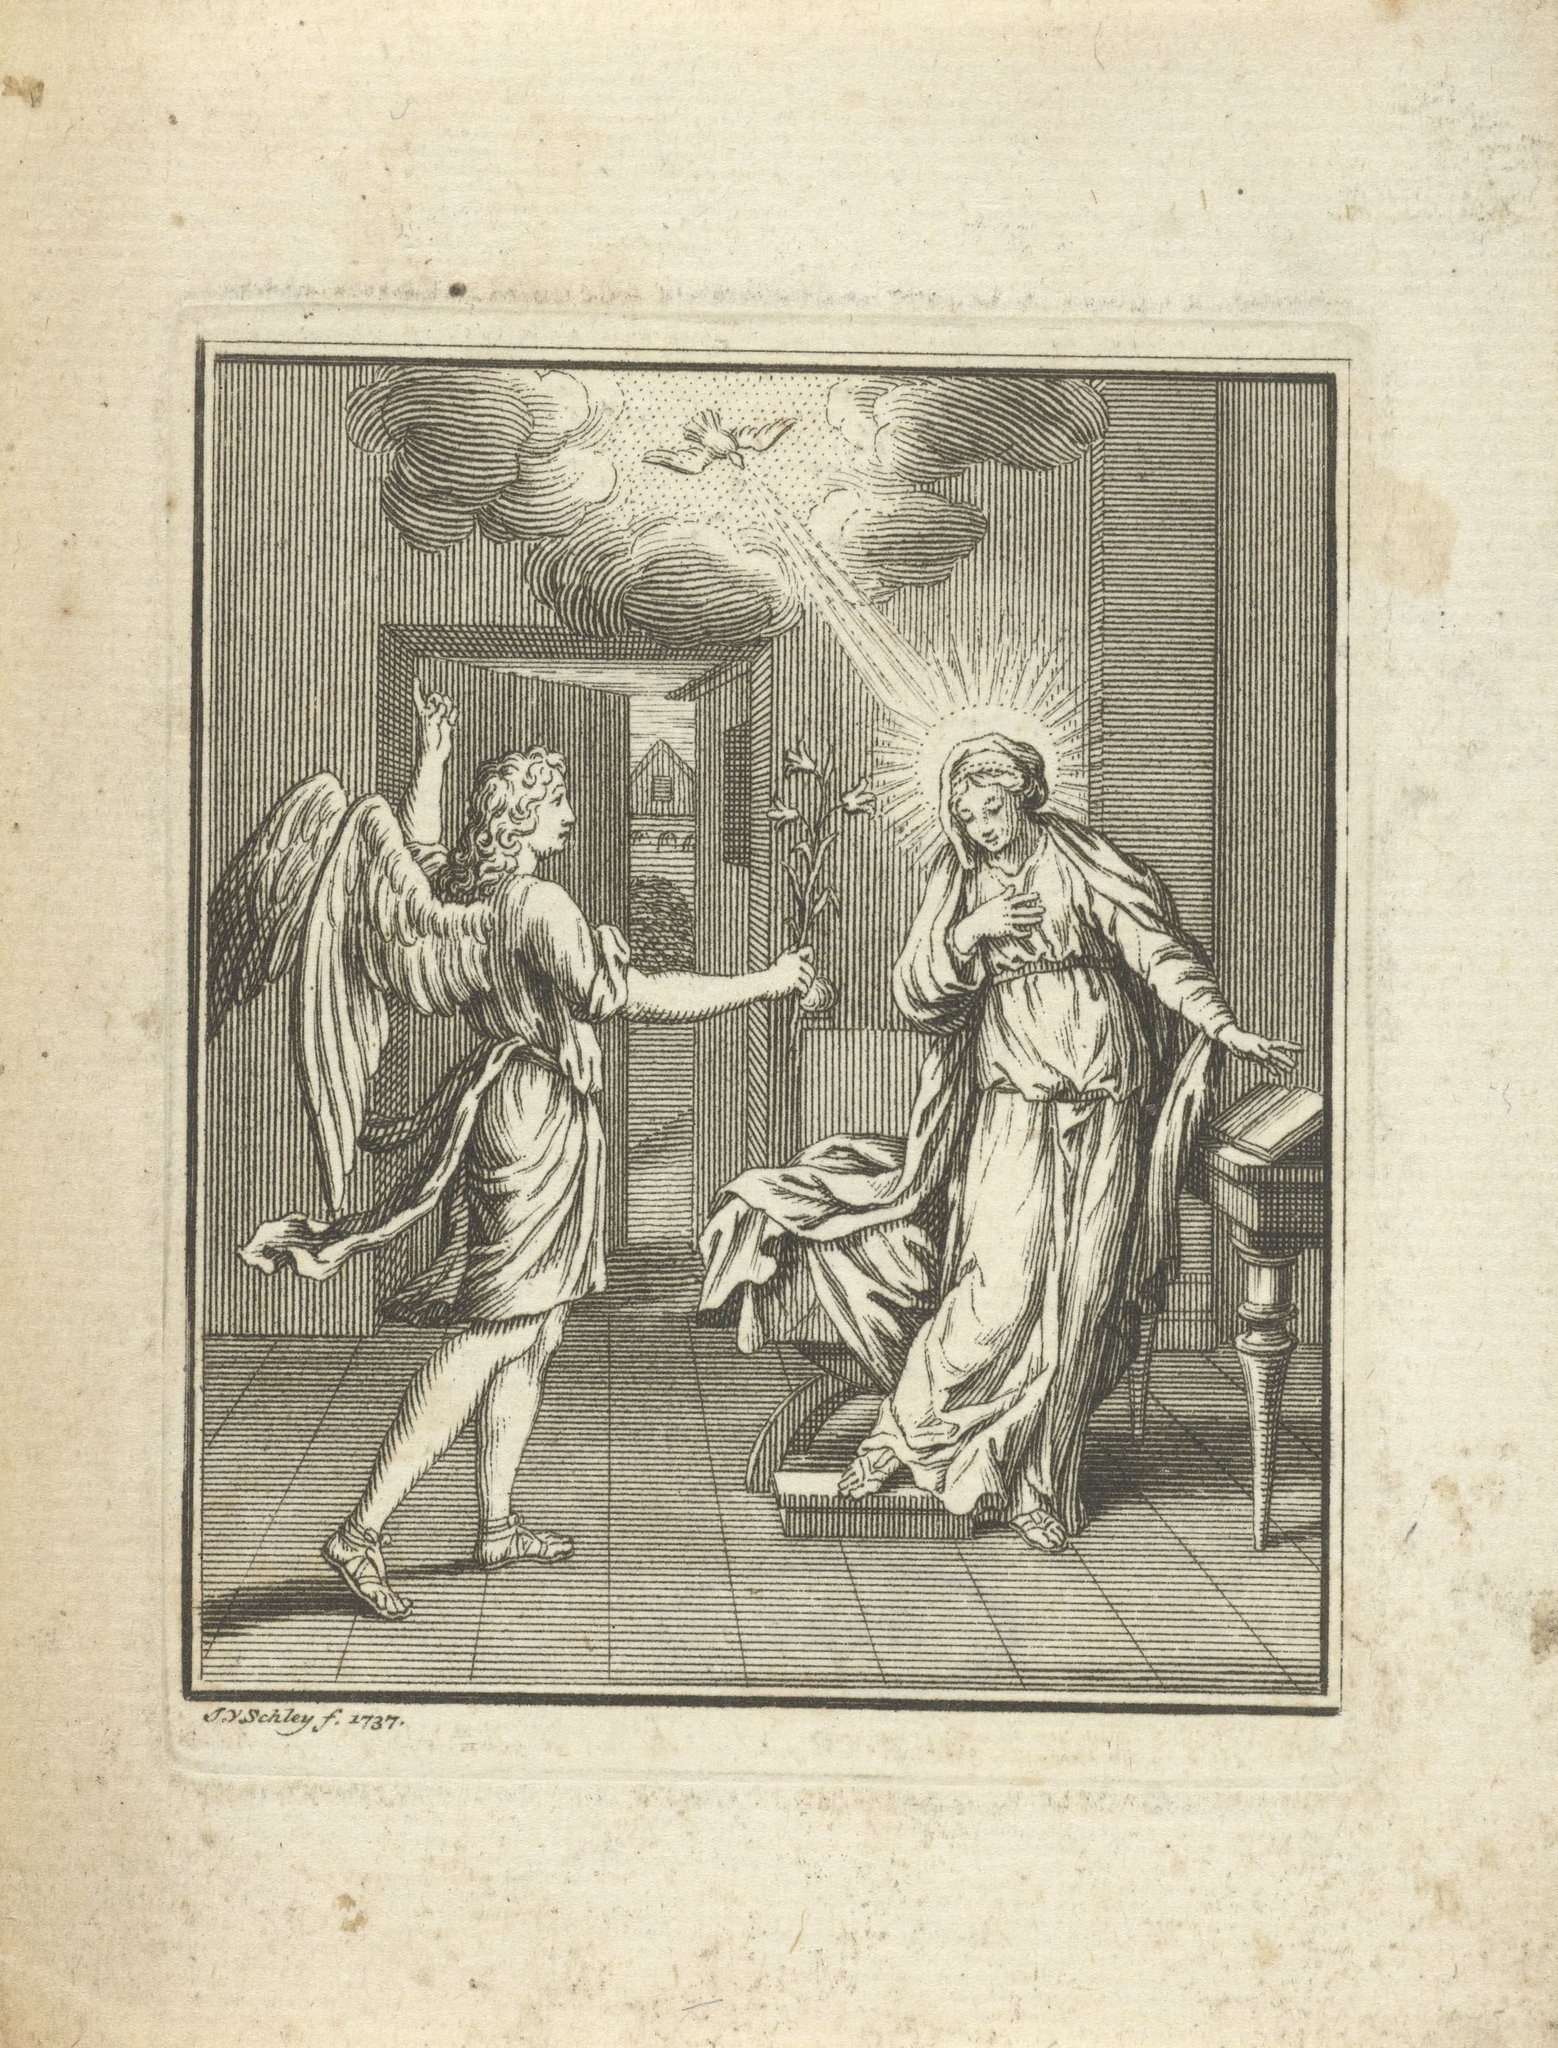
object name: print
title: Annunciatie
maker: jacob van der schley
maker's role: draughtsman, print maker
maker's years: 1715-1779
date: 1737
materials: paper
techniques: engraving, etching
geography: amsterdam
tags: the annunciation: mary, usually reading, is visited by the angel (sometimes a woman overhears the conversation) (+ holy trinity)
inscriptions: collector's mark: Lugt 2228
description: De aankondiging van de geboorte van Christus aan Maria: de engel Gabriël verschijnt aan Maria en geeft haar een lelie. De Heilige Geest in de gedaante van een duif vliegt op Maria af.